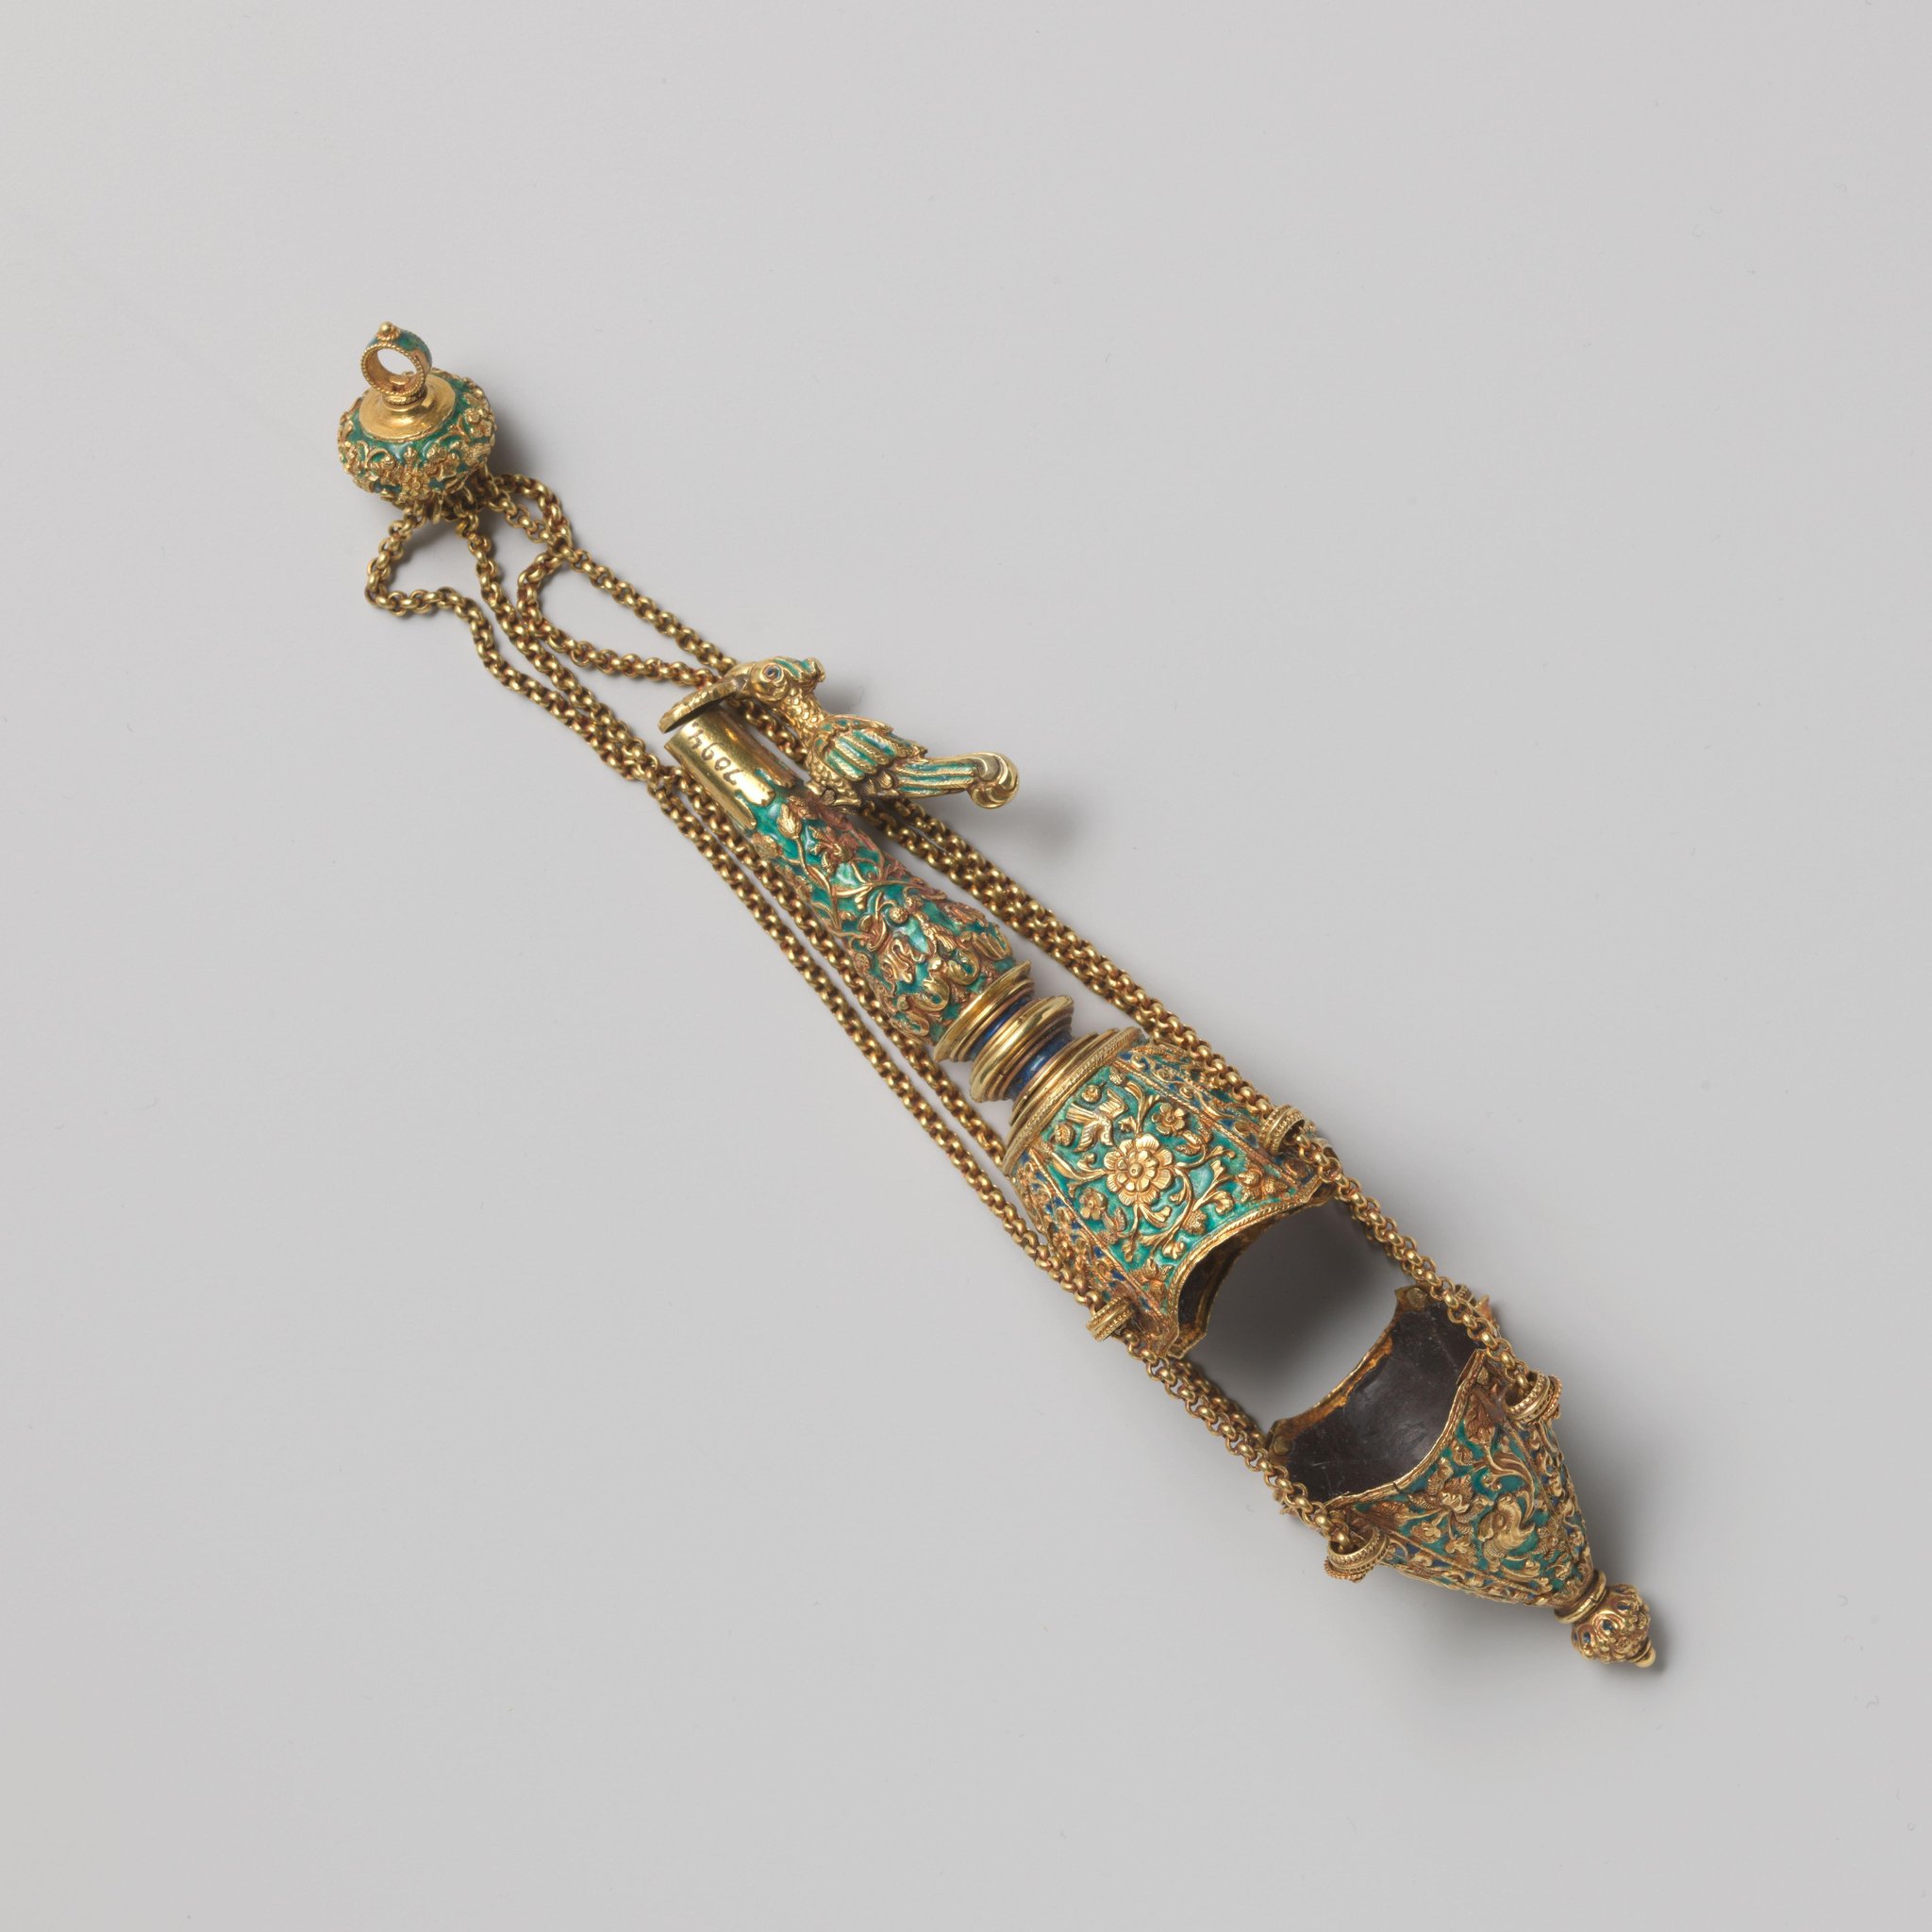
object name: jewellery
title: Kruithoorn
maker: Anonymous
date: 1700-1800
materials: gold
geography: sri lanka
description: Sieraad van gedreven goud met groen en blauw email. De buik ontbreekt. Met vier gouden kettingen.